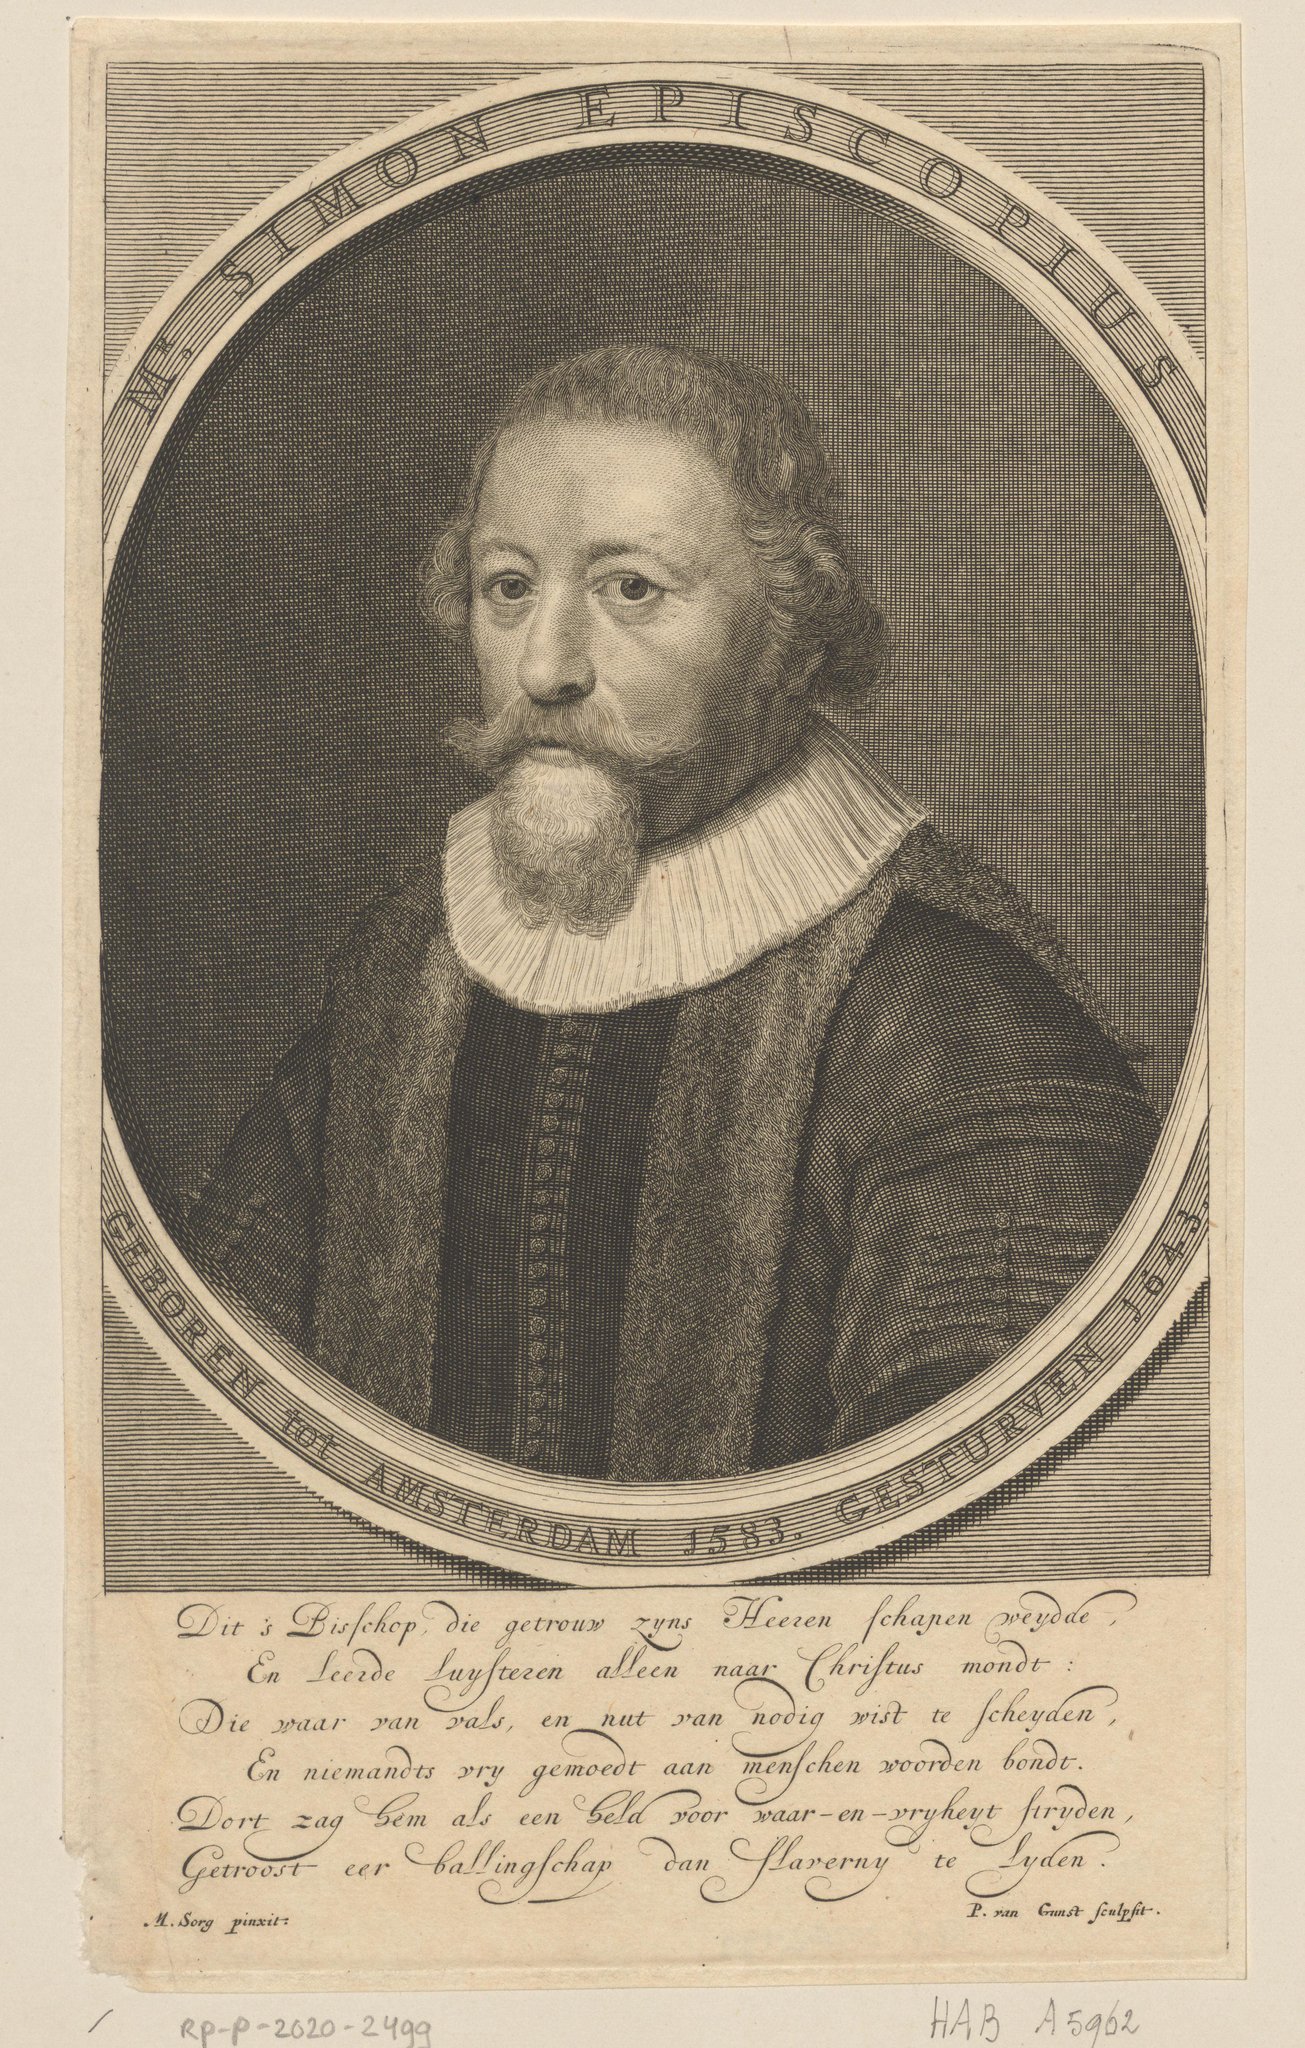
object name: print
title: Portret van Simon Episcopius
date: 1659-1731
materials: paper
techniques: engraving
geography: amsterdam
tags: theologian, historical persons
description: Met zesregelig vers in het Nederlands onder het portret.